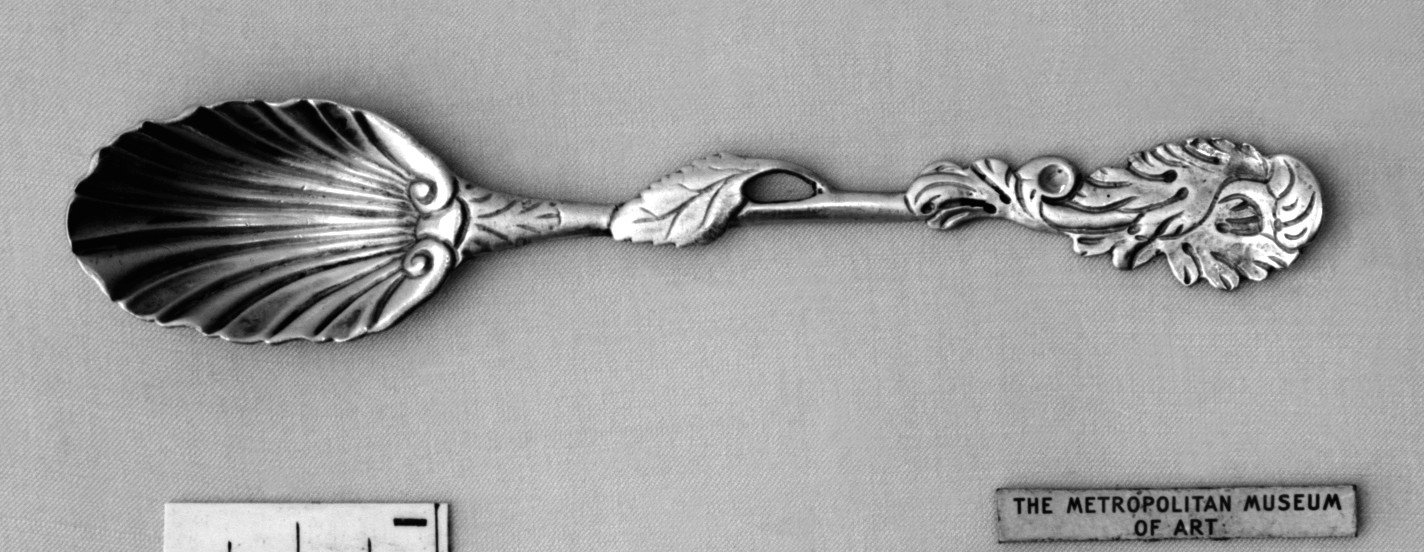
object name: salt spoon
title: Salt spoon (?)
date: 1801-1833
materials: silver